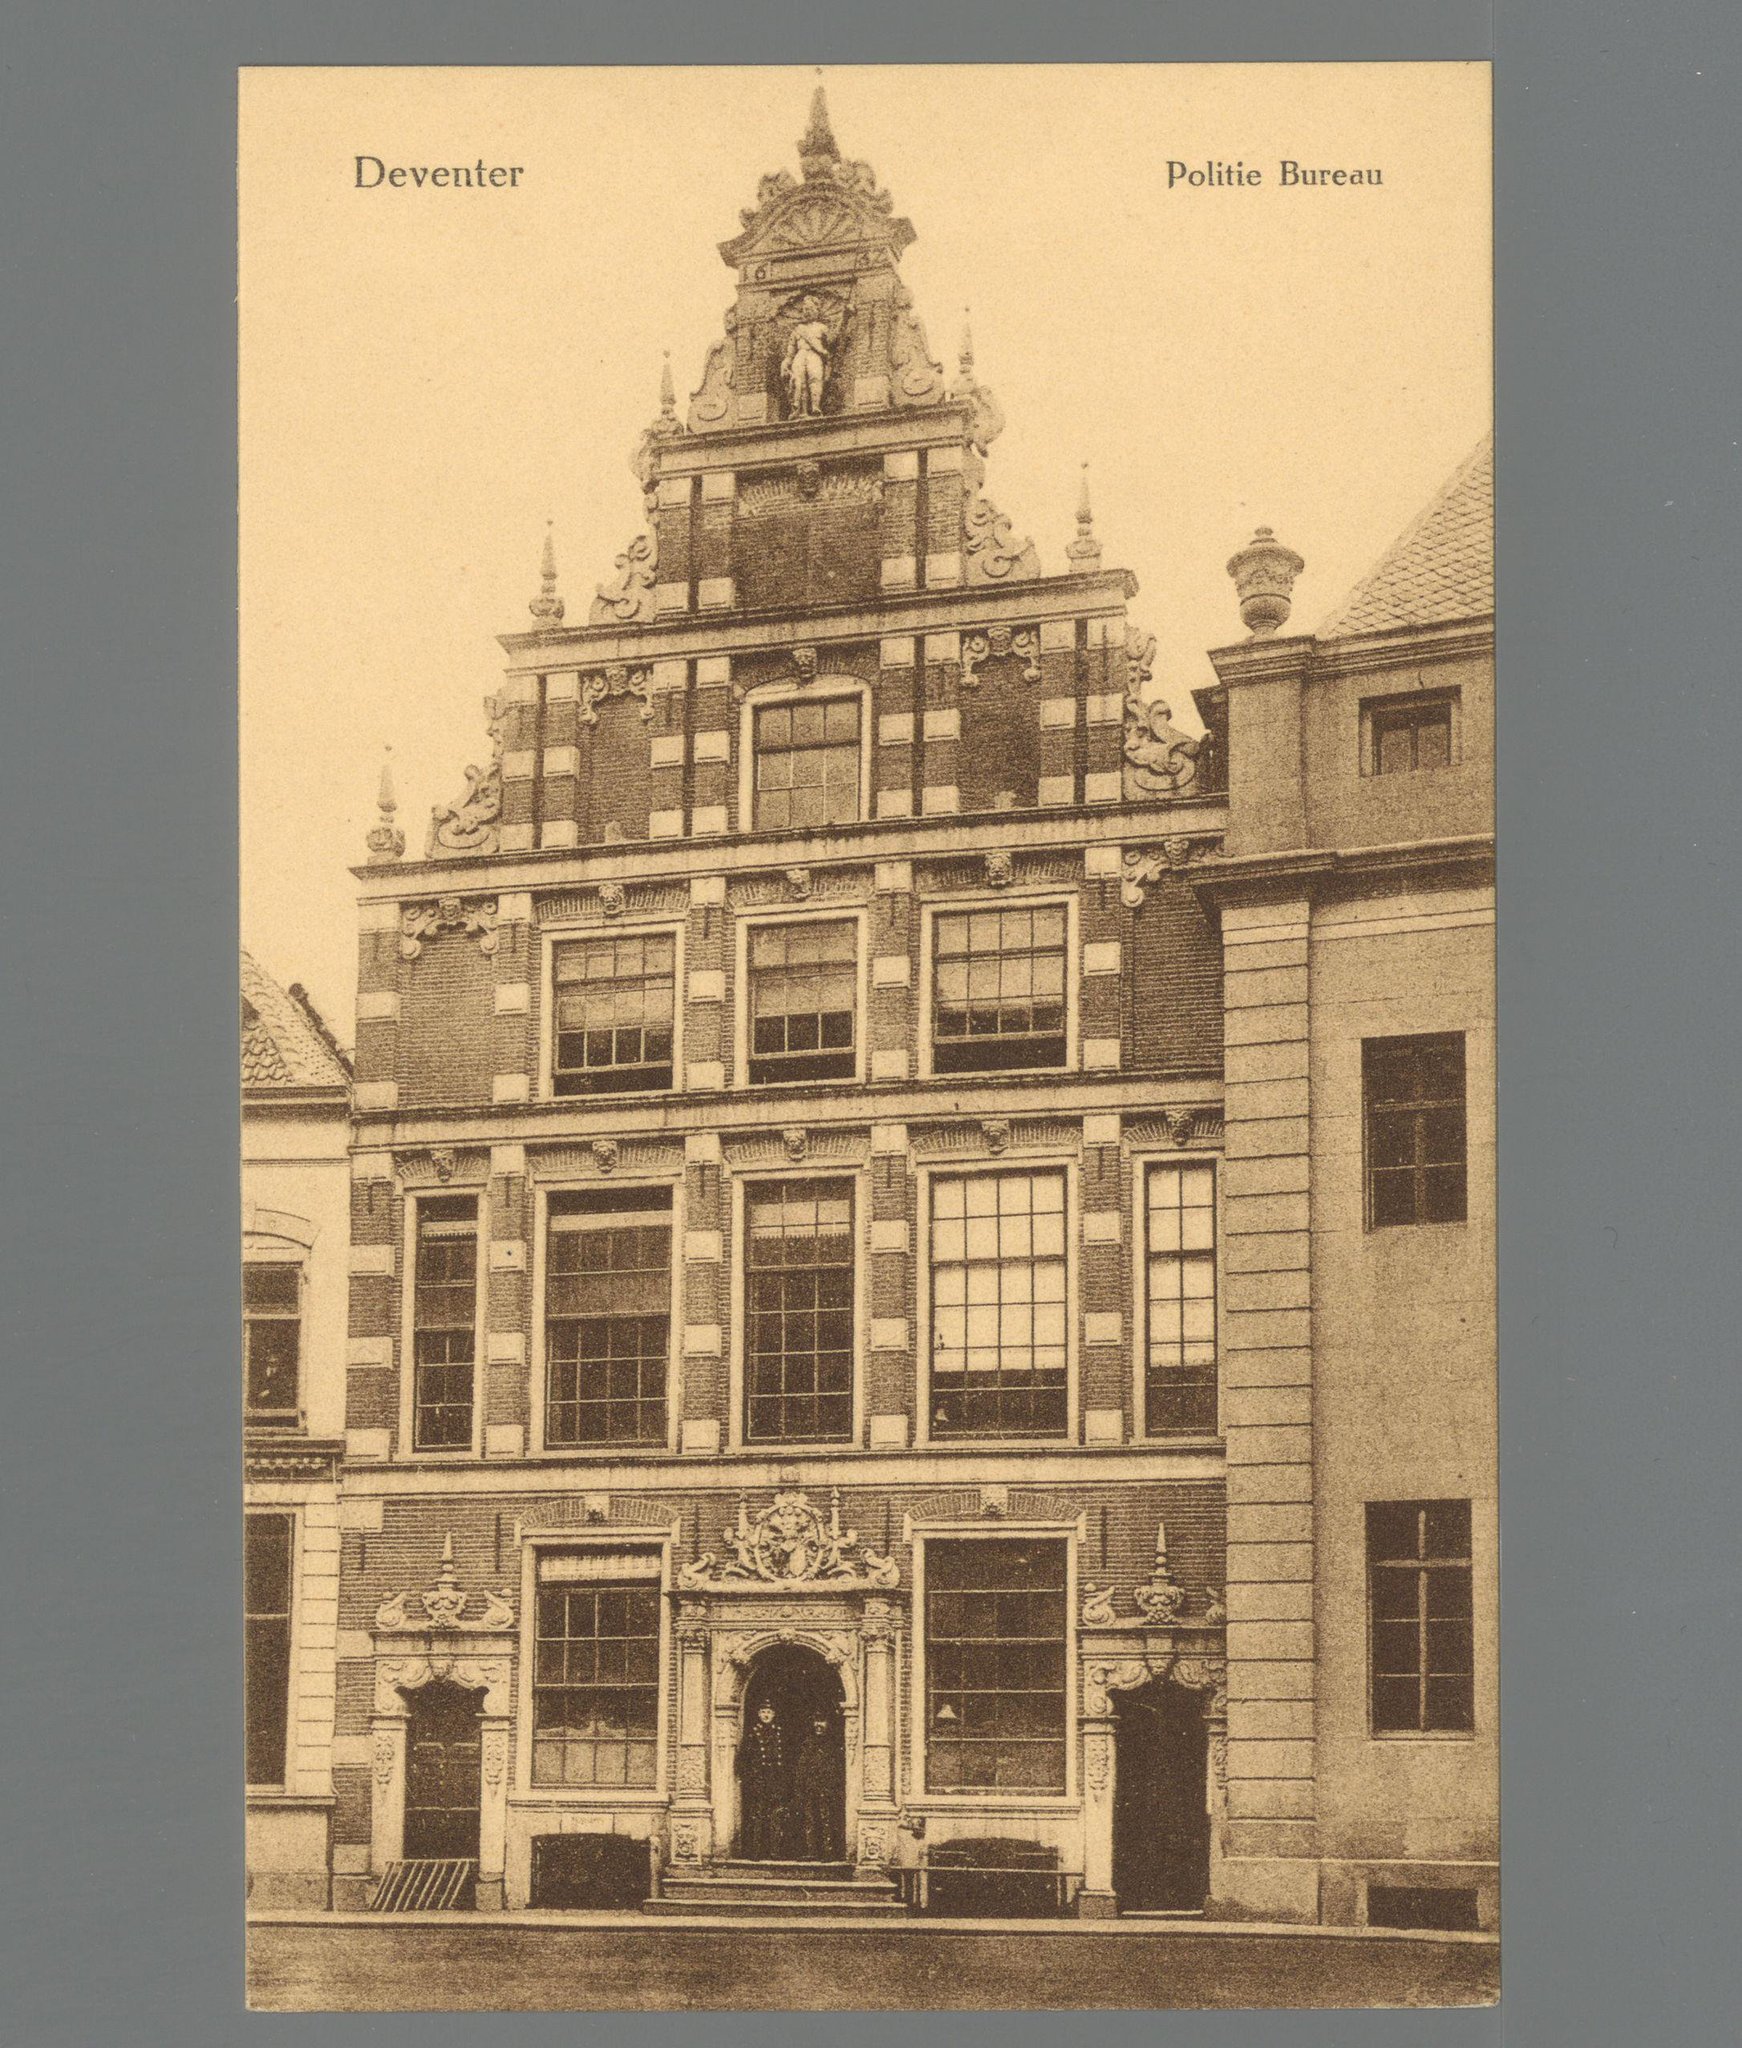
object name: photomechanical print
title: Deventer. Politie Bureau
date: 1905-1930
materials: cardboard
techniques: photograph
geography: deventer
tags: façade (of house or building), police, deventer